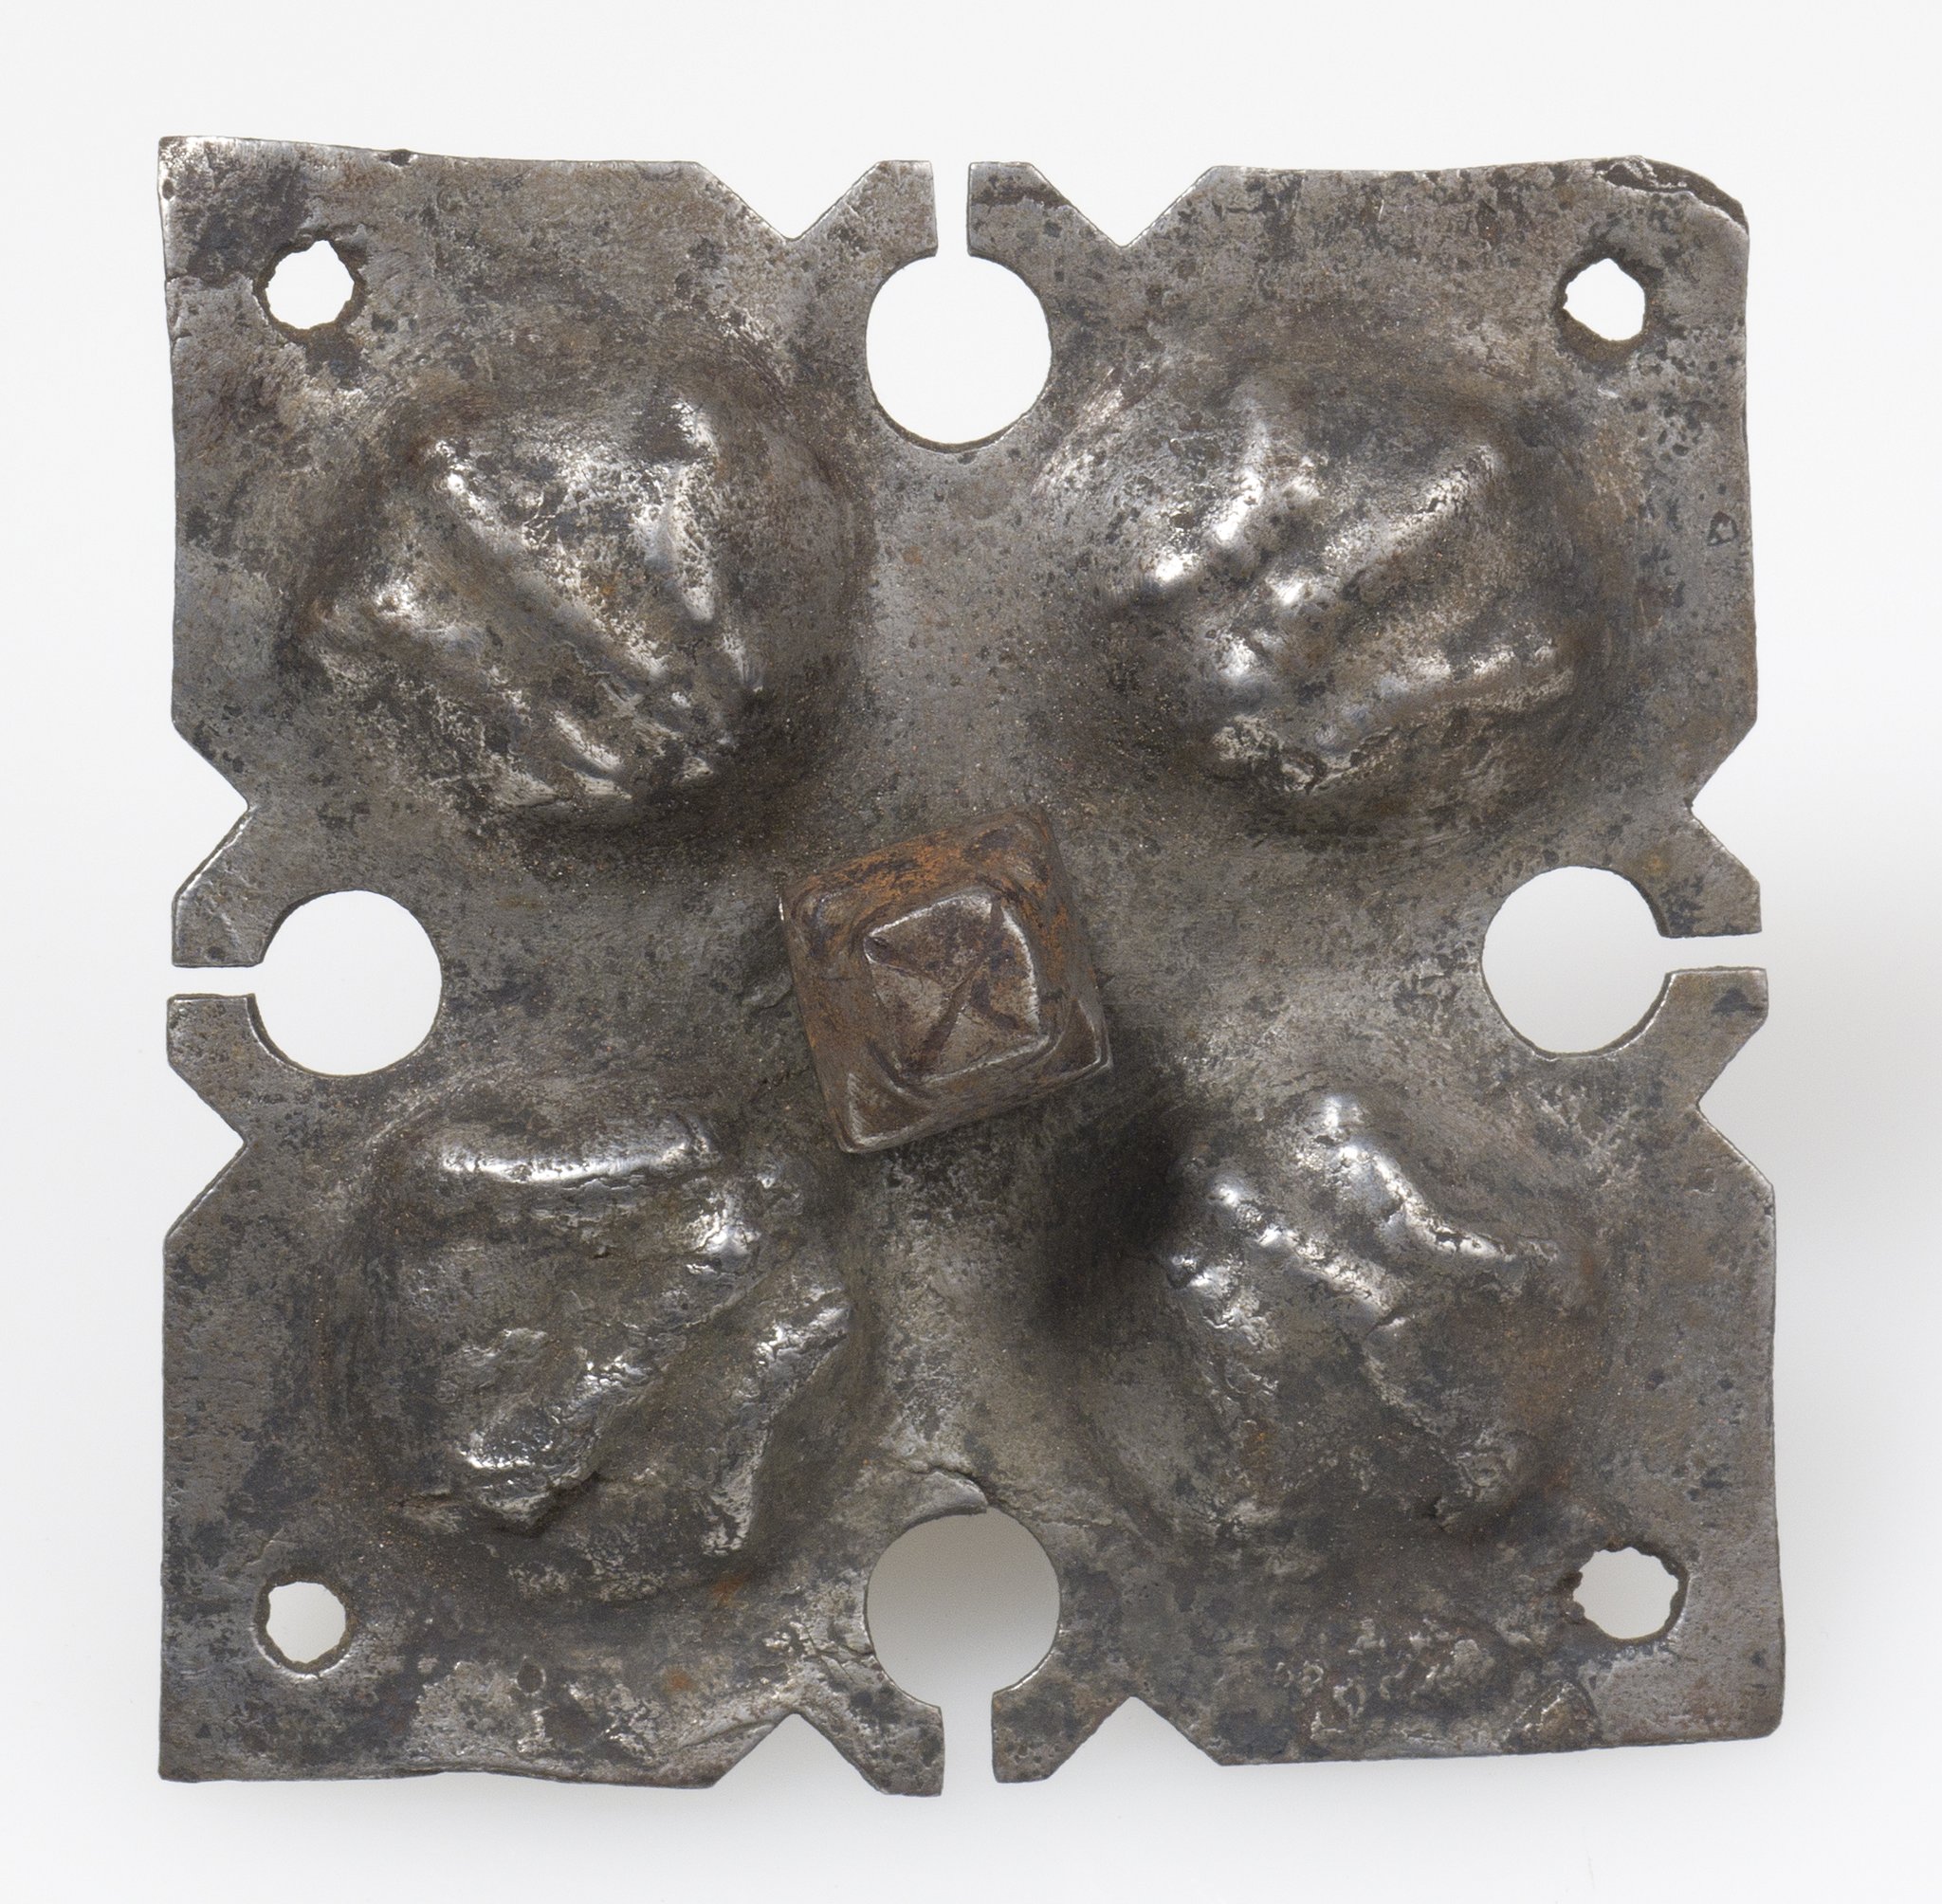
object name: plate and nail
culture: european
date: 1401-1600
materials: iron